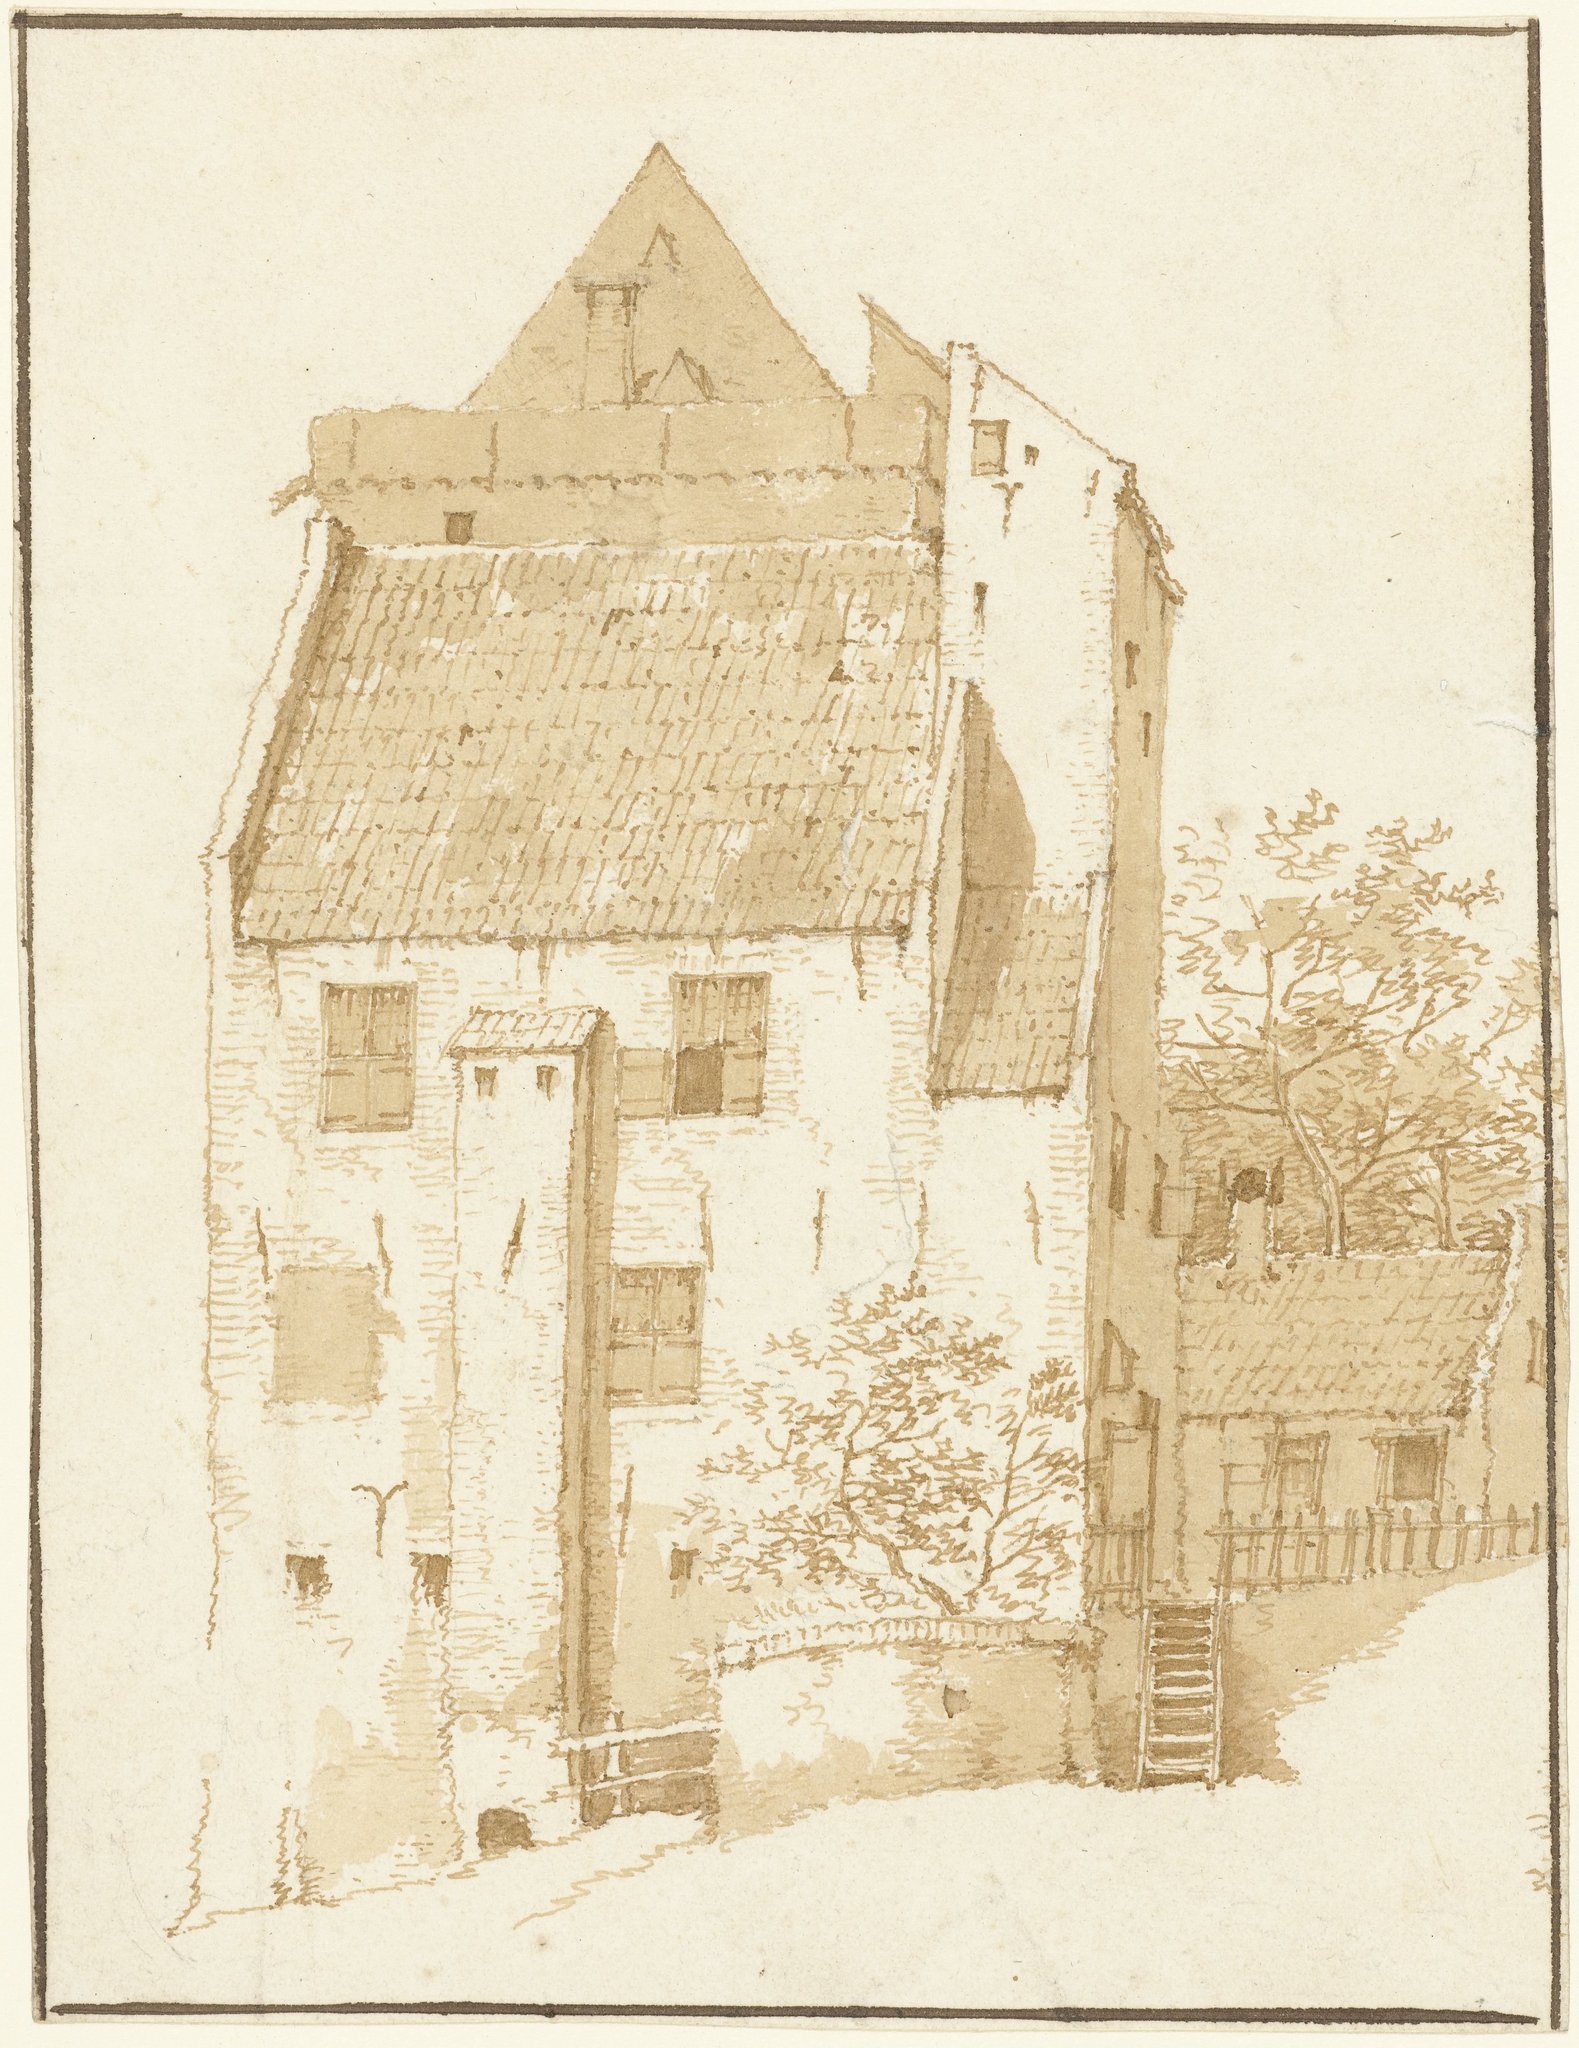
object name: drawing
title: Walmuur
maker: daniël kerkhoff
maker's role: draughtsman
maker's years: 1766-1821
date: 1776-1821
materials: ink, paper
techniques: brush, pen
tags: city-walls